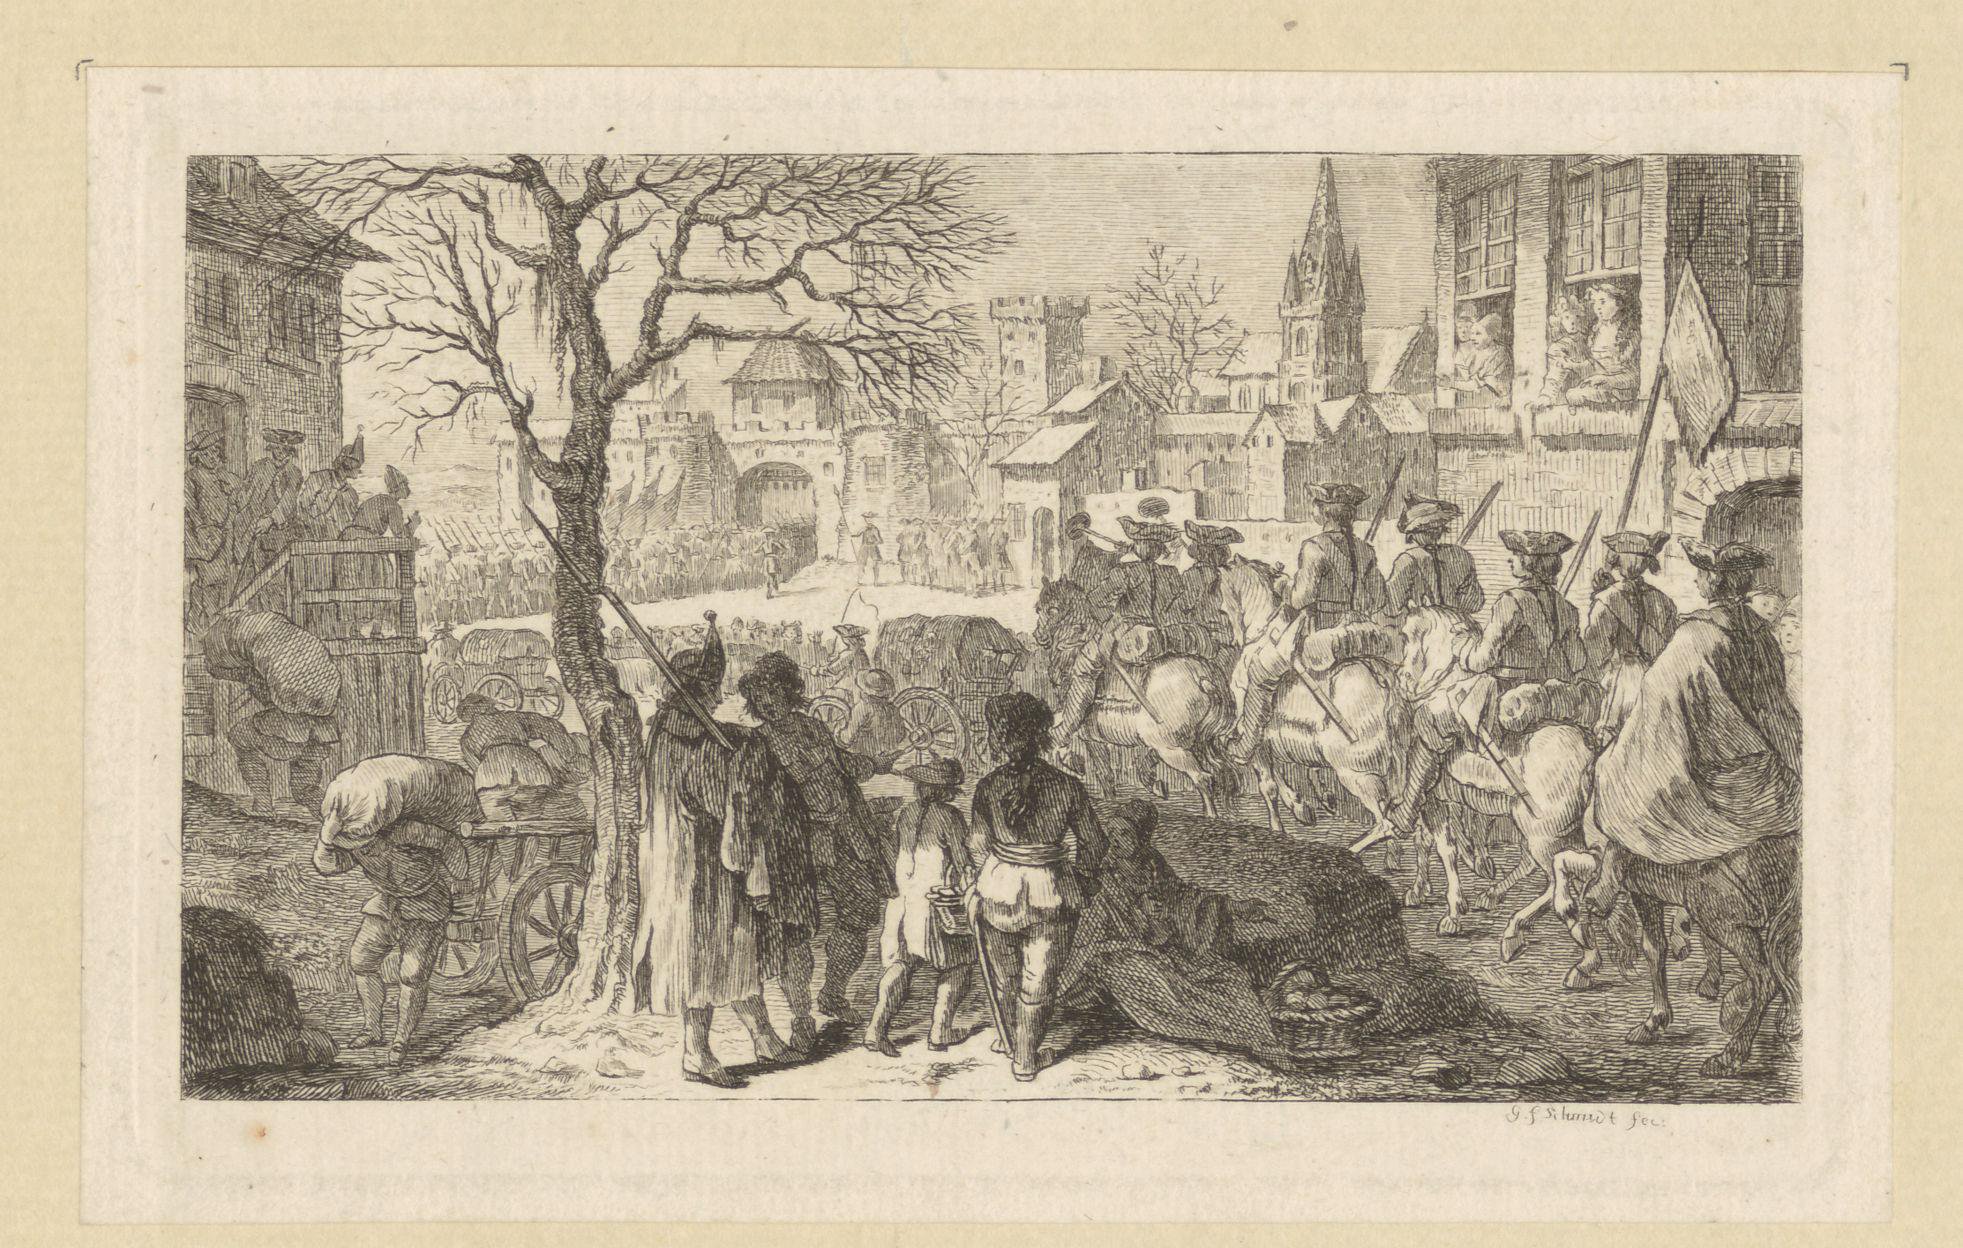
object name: print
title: Intocht van overwinnaars in een stad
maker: georg friedrich schmidt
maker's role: draughtsman, print maker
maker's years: 1712-1775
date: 1760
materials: paper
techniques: etching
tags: march into the conquered place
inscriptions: collector's mark: Lugt 240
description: Prent ook gebruikt in: Frederik de Grote. Poësies diverses. Sanssouci, Frederik de Grote, 1760.